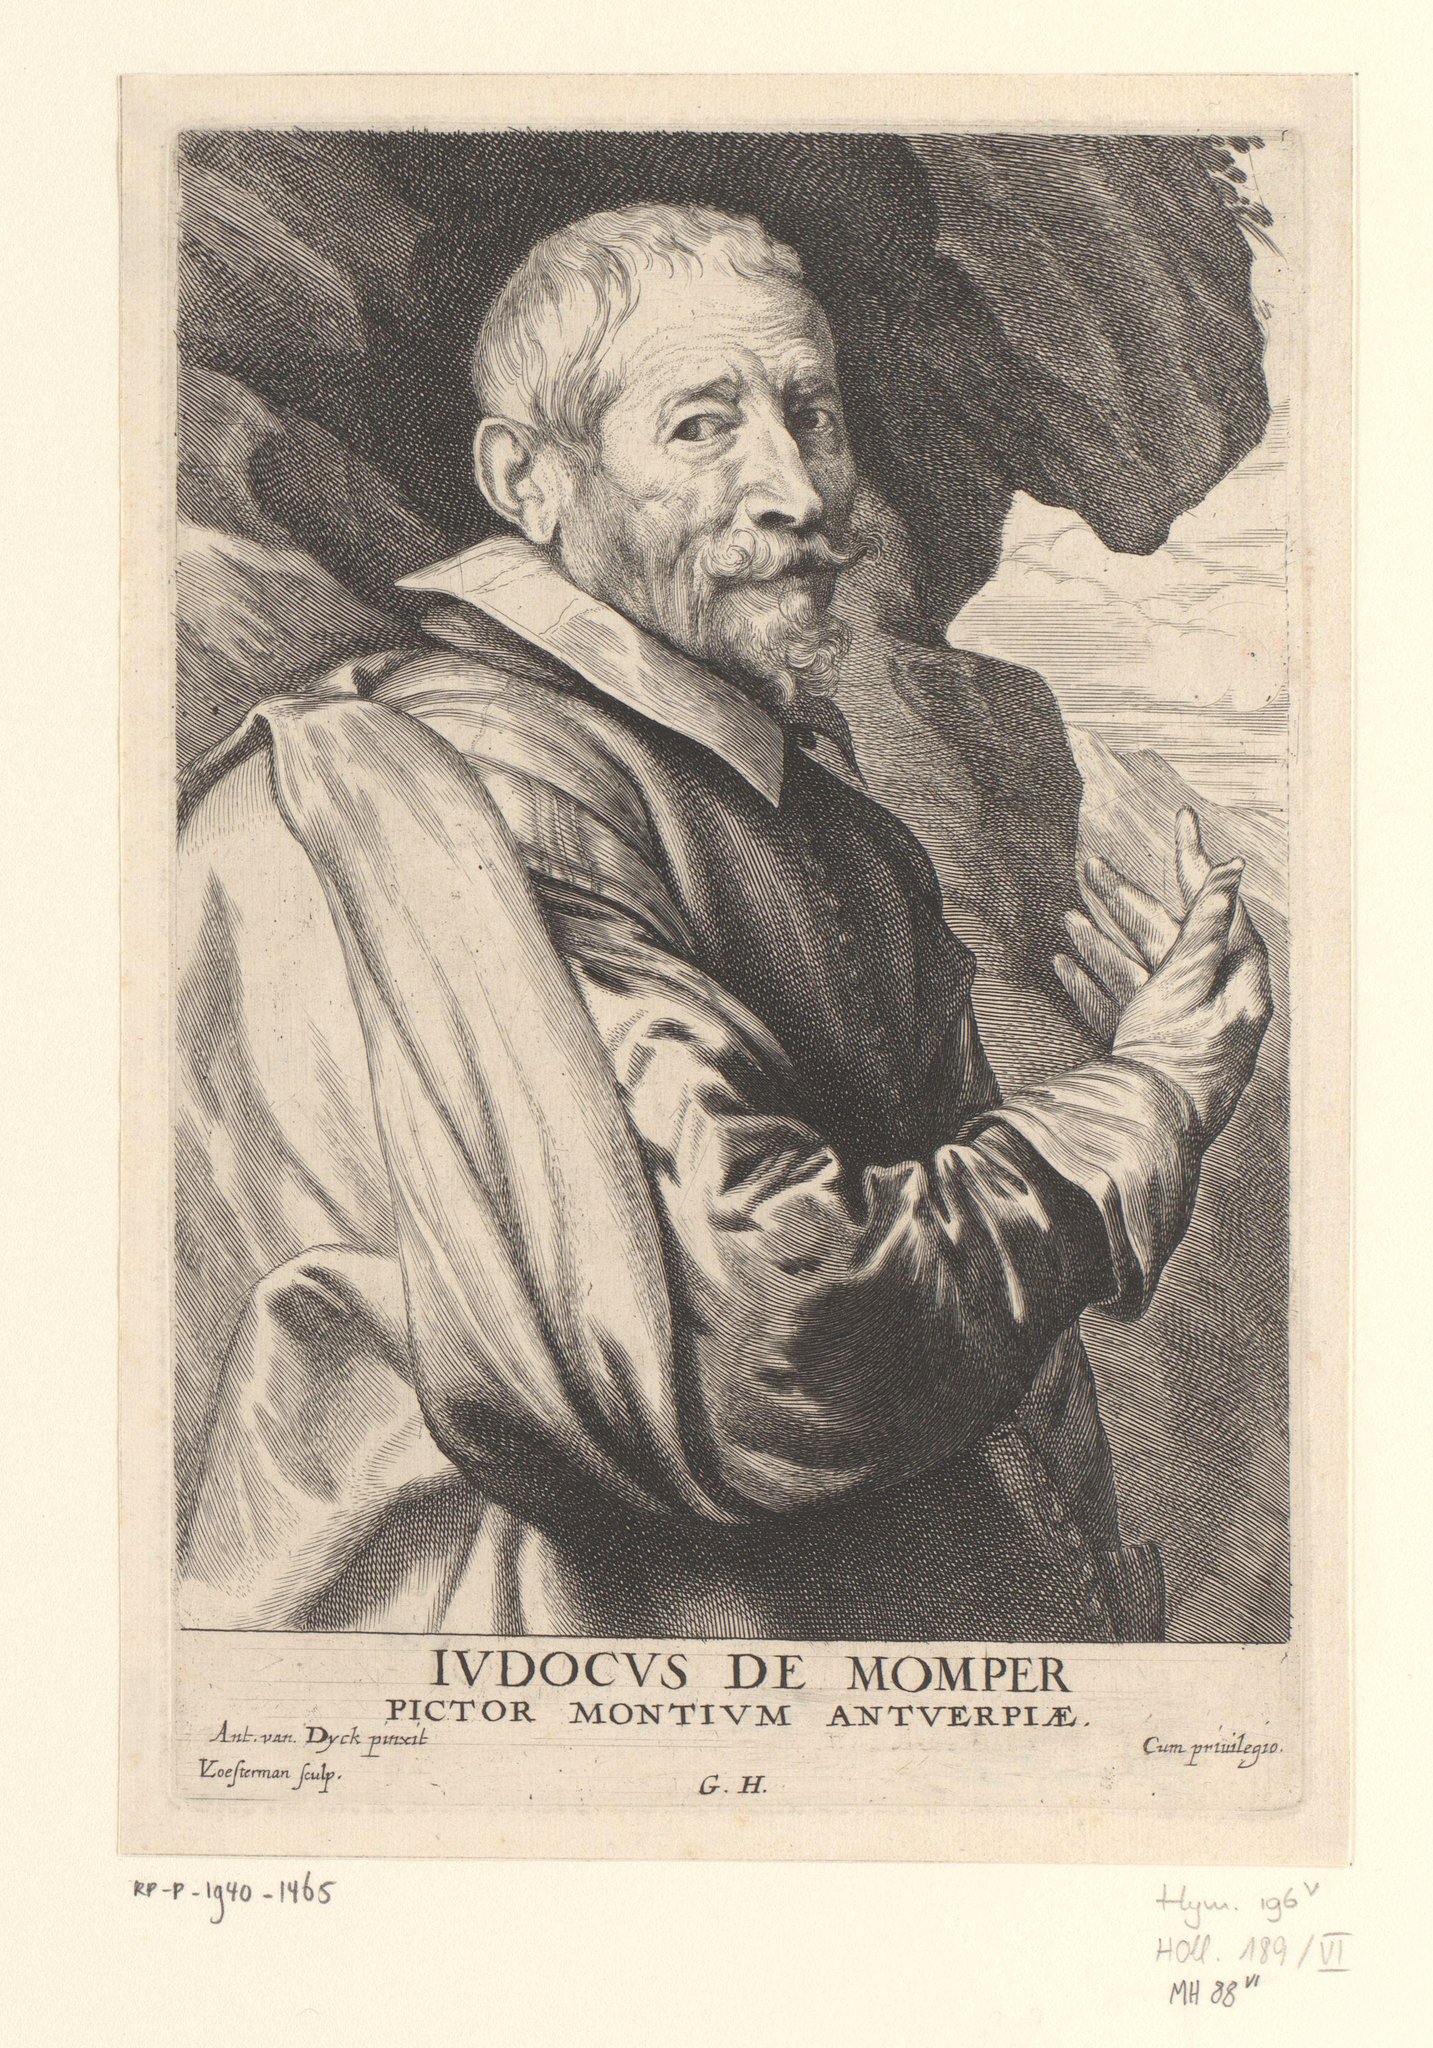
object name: print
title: Portret van Joos de Momper II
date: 1645-1646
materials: paper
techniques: engraving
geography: antwerp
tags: antwerp, painter, draughtsman, joos de momper (ii)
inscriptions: collector's mark: Lugt 2166, collector's mark: Lugt 2760, collector's mark: Lugt 2228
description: Prent gebruikt voor: Icones principum, virorum doctorum, pictorum, chalcographorum, statuariorum nec non amatorum pictoriae artis numero centum ab Ant. van Dyck ad vivum expressae ejusque sumptibus aeri incisae. Antwerpen: Gillis Hendricx, [1645-1646].